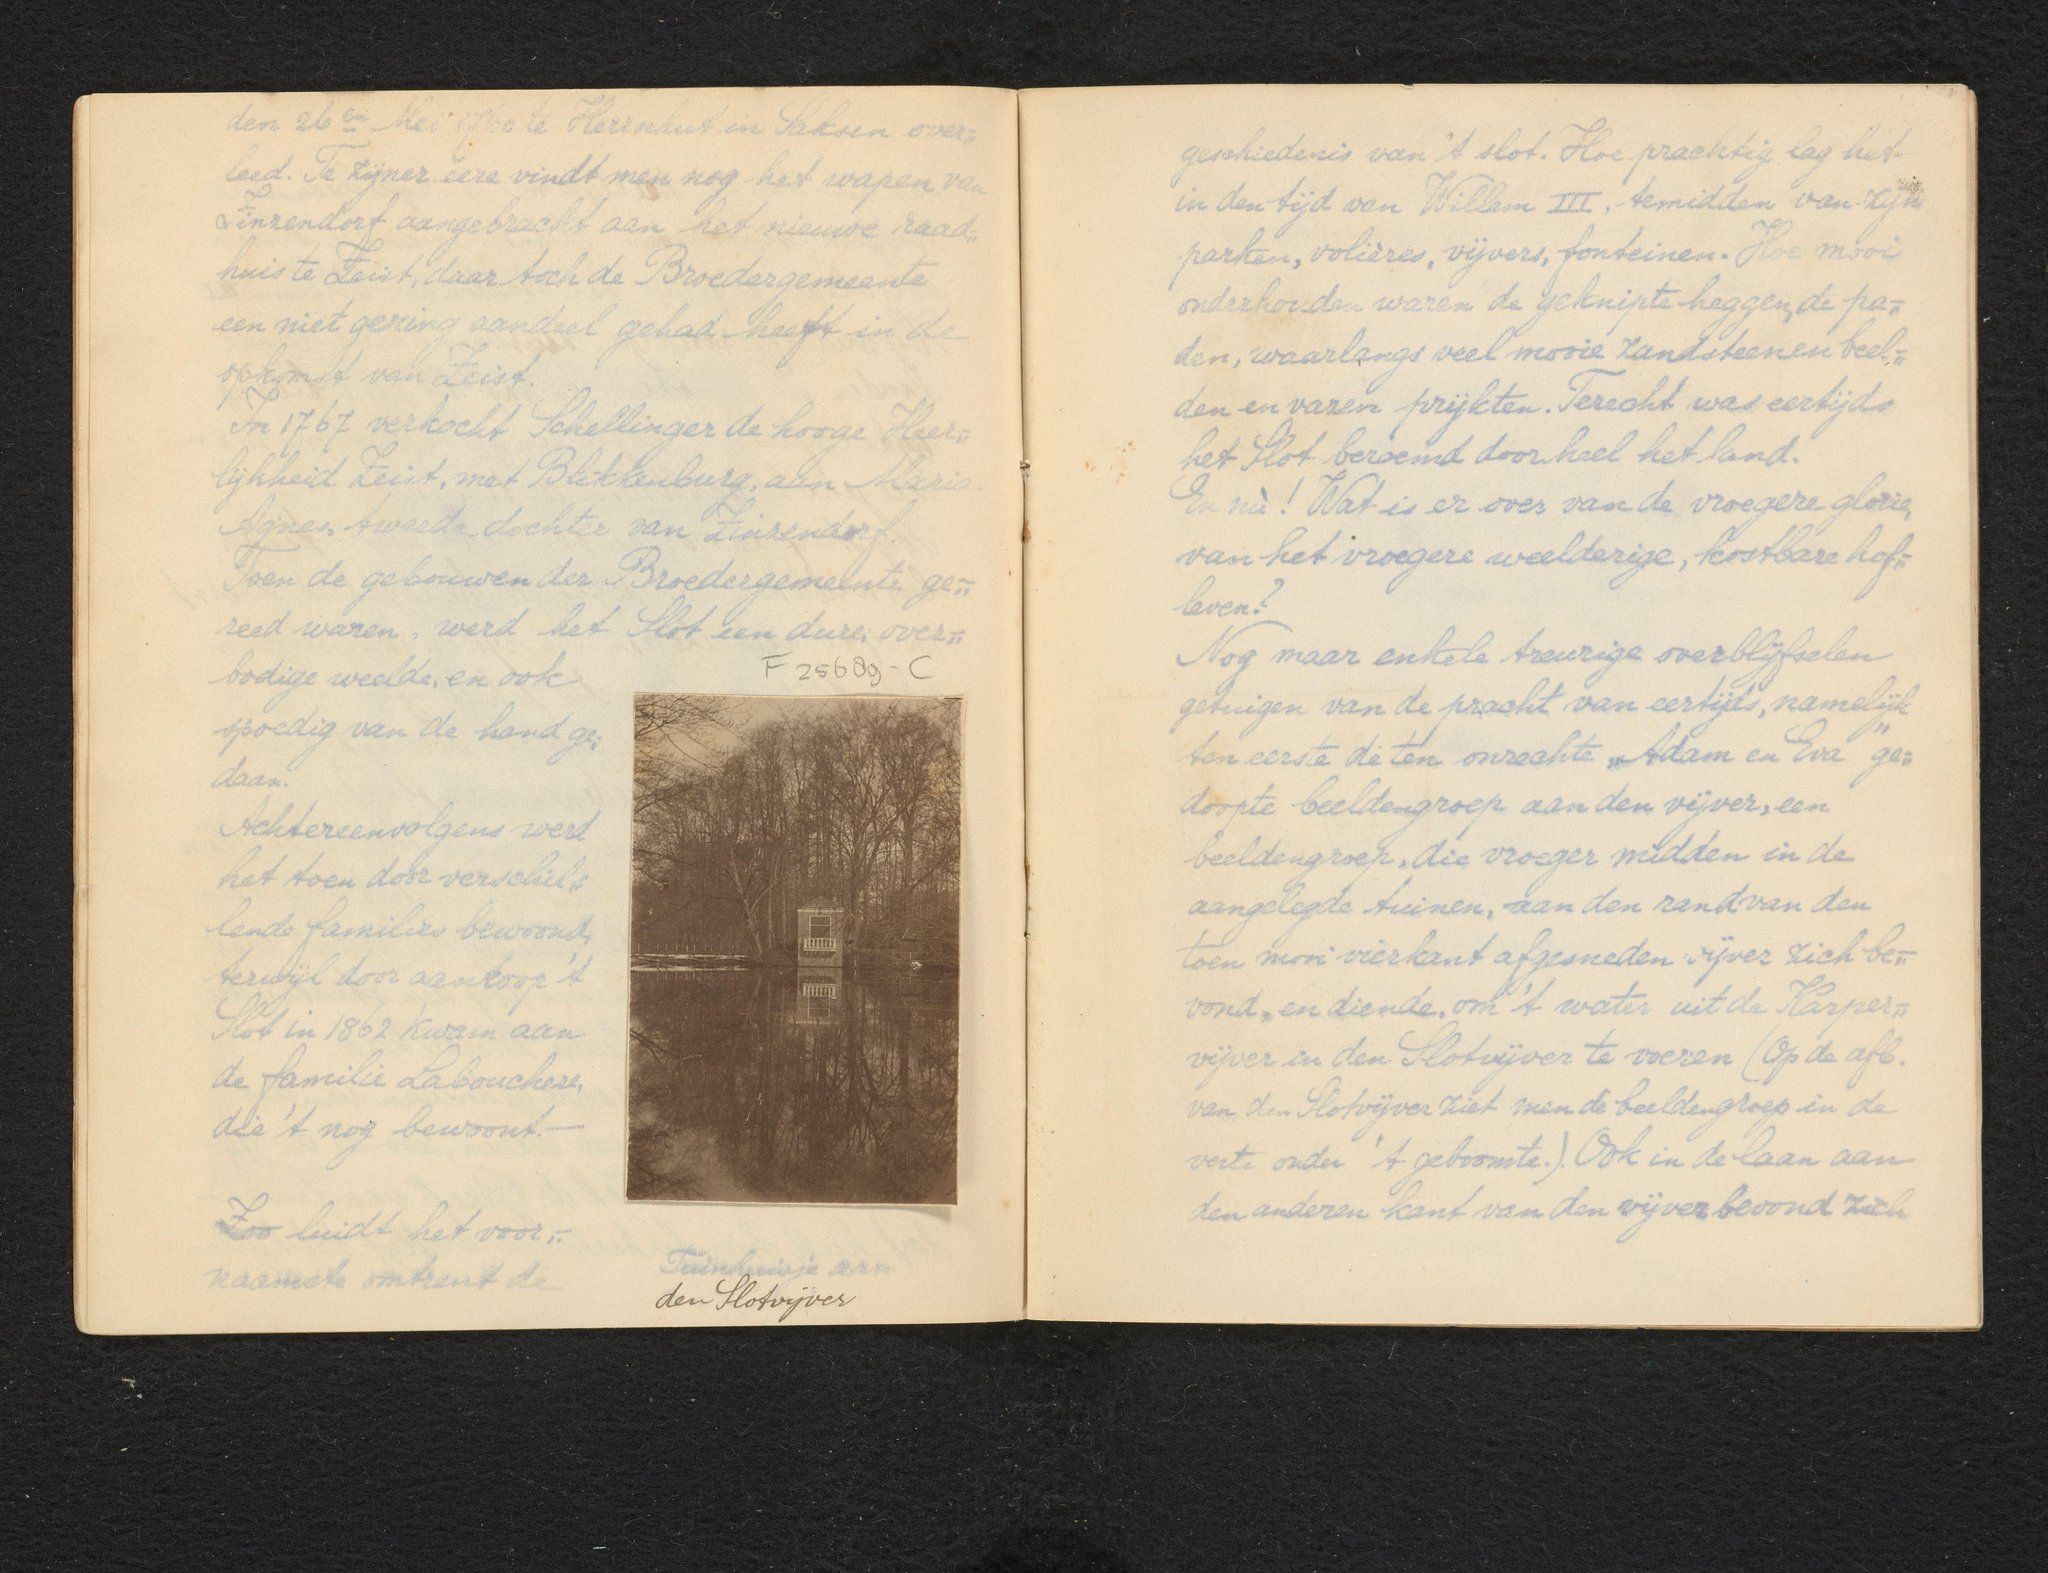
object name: photograph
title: Vijver bij Slot Zeist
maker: Anonymous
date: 1911-1916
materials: paper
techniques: gelatin silver print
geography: zeist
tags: pond, pool